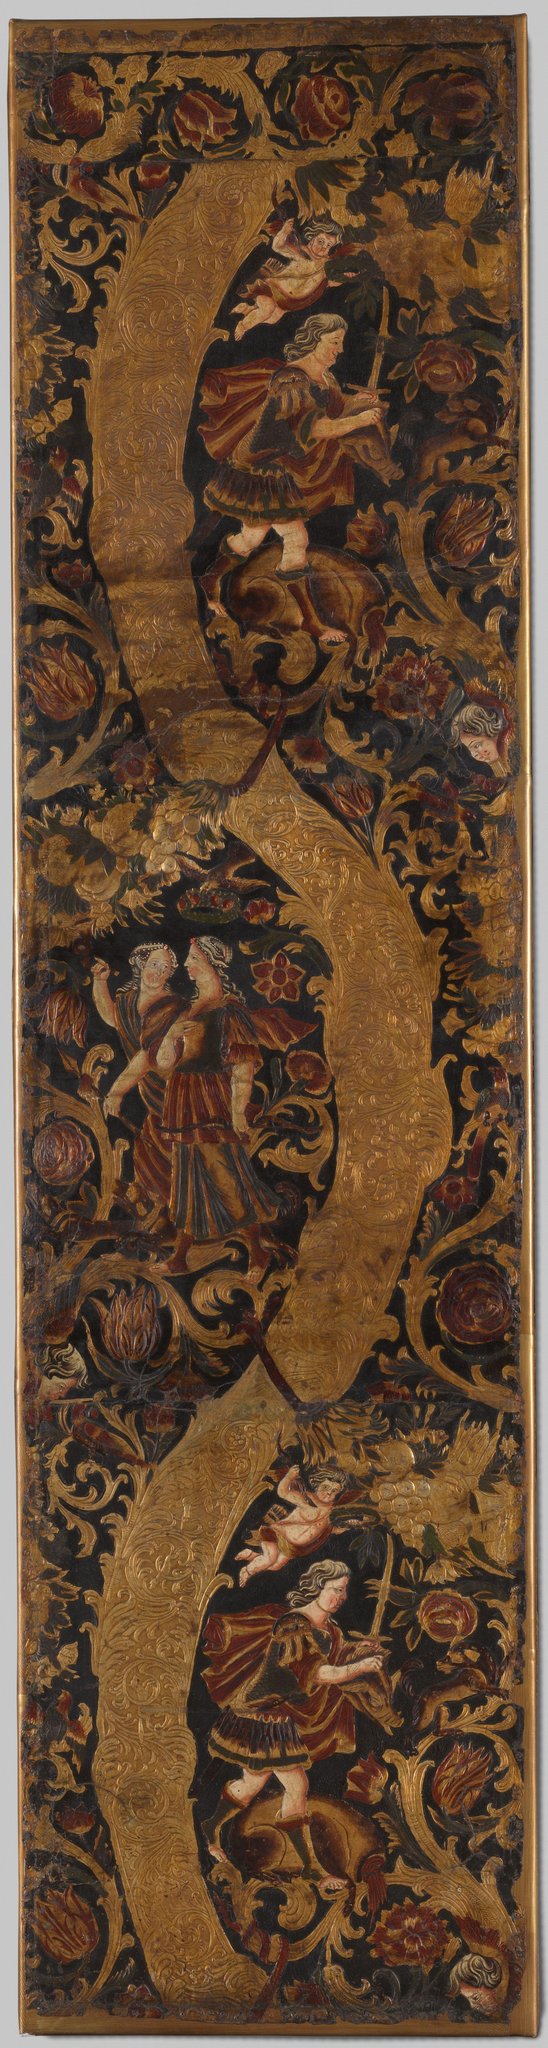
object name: vouwscherm, kamerscherm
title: Onderdeel van een kamerscherm bekleed met gepolychromeerd goudleer met bloem-, vrucht- en bladranken en mythologische jachtvoorstelling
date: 1630-1650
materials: gilt leather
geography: amsterdam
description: Onderdeel van een kamerscherm bekleed met gepolychromeerd goudleer. Tegen een donkere achtergrond en binnen een kader, gevormd door breed verguld bandwerk en omgeven door bloem, vrucht- en bladranken is een mythologische jachtvoorstelling weergegeven: Atalantha en Meleager. Goudleer ca. 1640. Opmerking: vergelijk ook met BK-NM-12728-A,B.